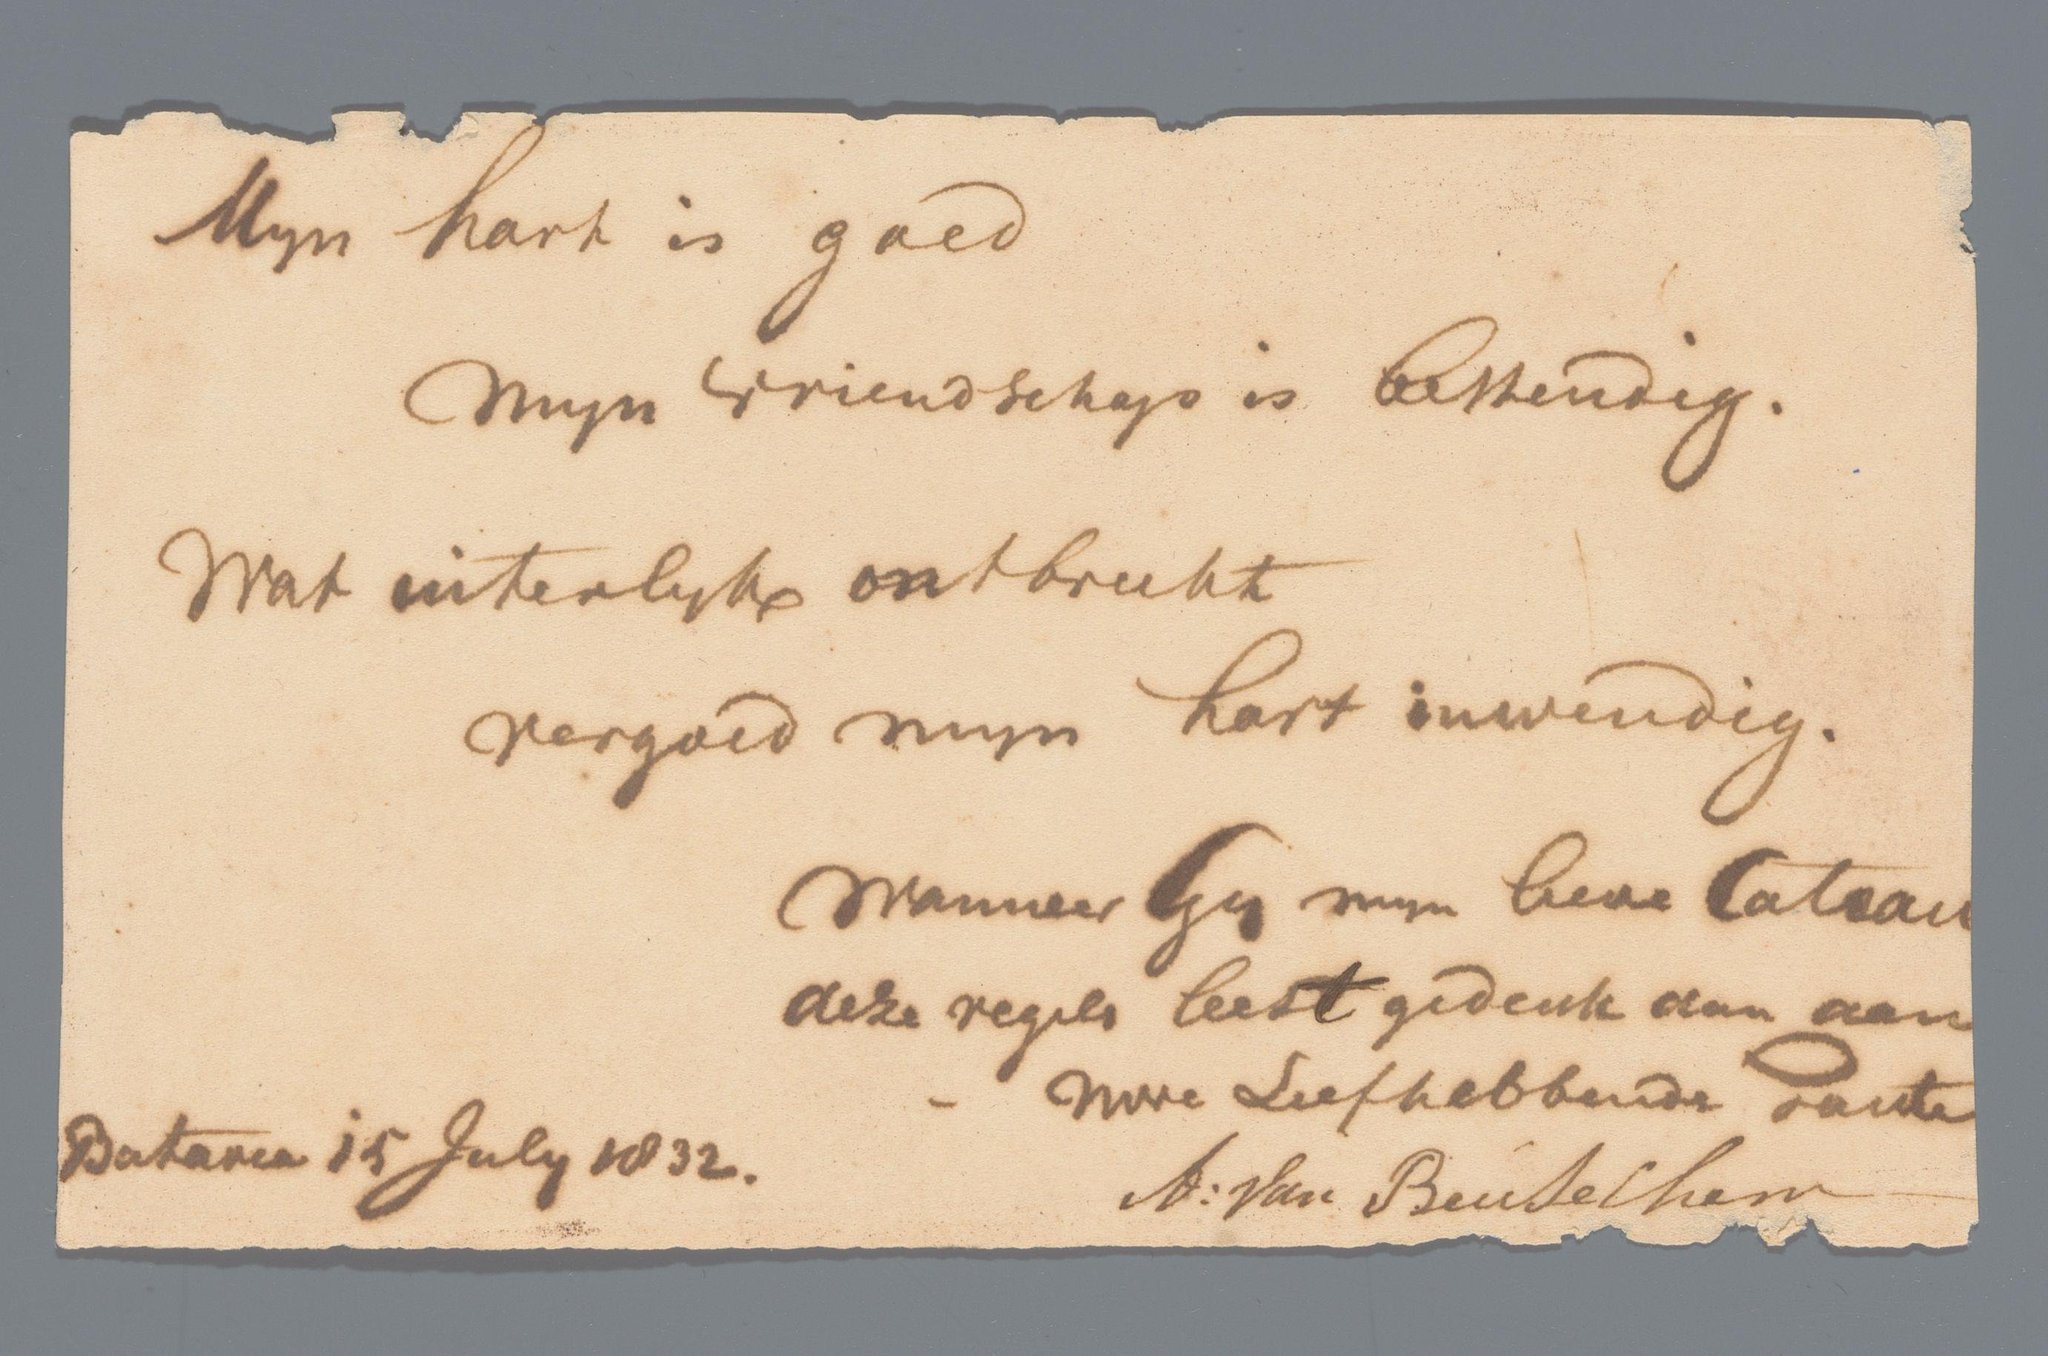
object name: document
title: Albumblad van tante A. van Beusechem aan Cateau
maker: Anonymous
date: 1832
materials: paper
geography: jakarta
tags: a. van beusechem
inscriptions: date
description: Klein papier met daarop de volgende tekst: "Mijn hart is goed mijn vriendschap is bestemdig. Wat uiterlijk ontbreekt vergoed mijn hart inwendig. Wanneer Gij mijn lieve Cateau deze regels leest gedenk dan aan uwe liefhebbende Tante A. van Beusechem. Batavia, 15 juli 1832".